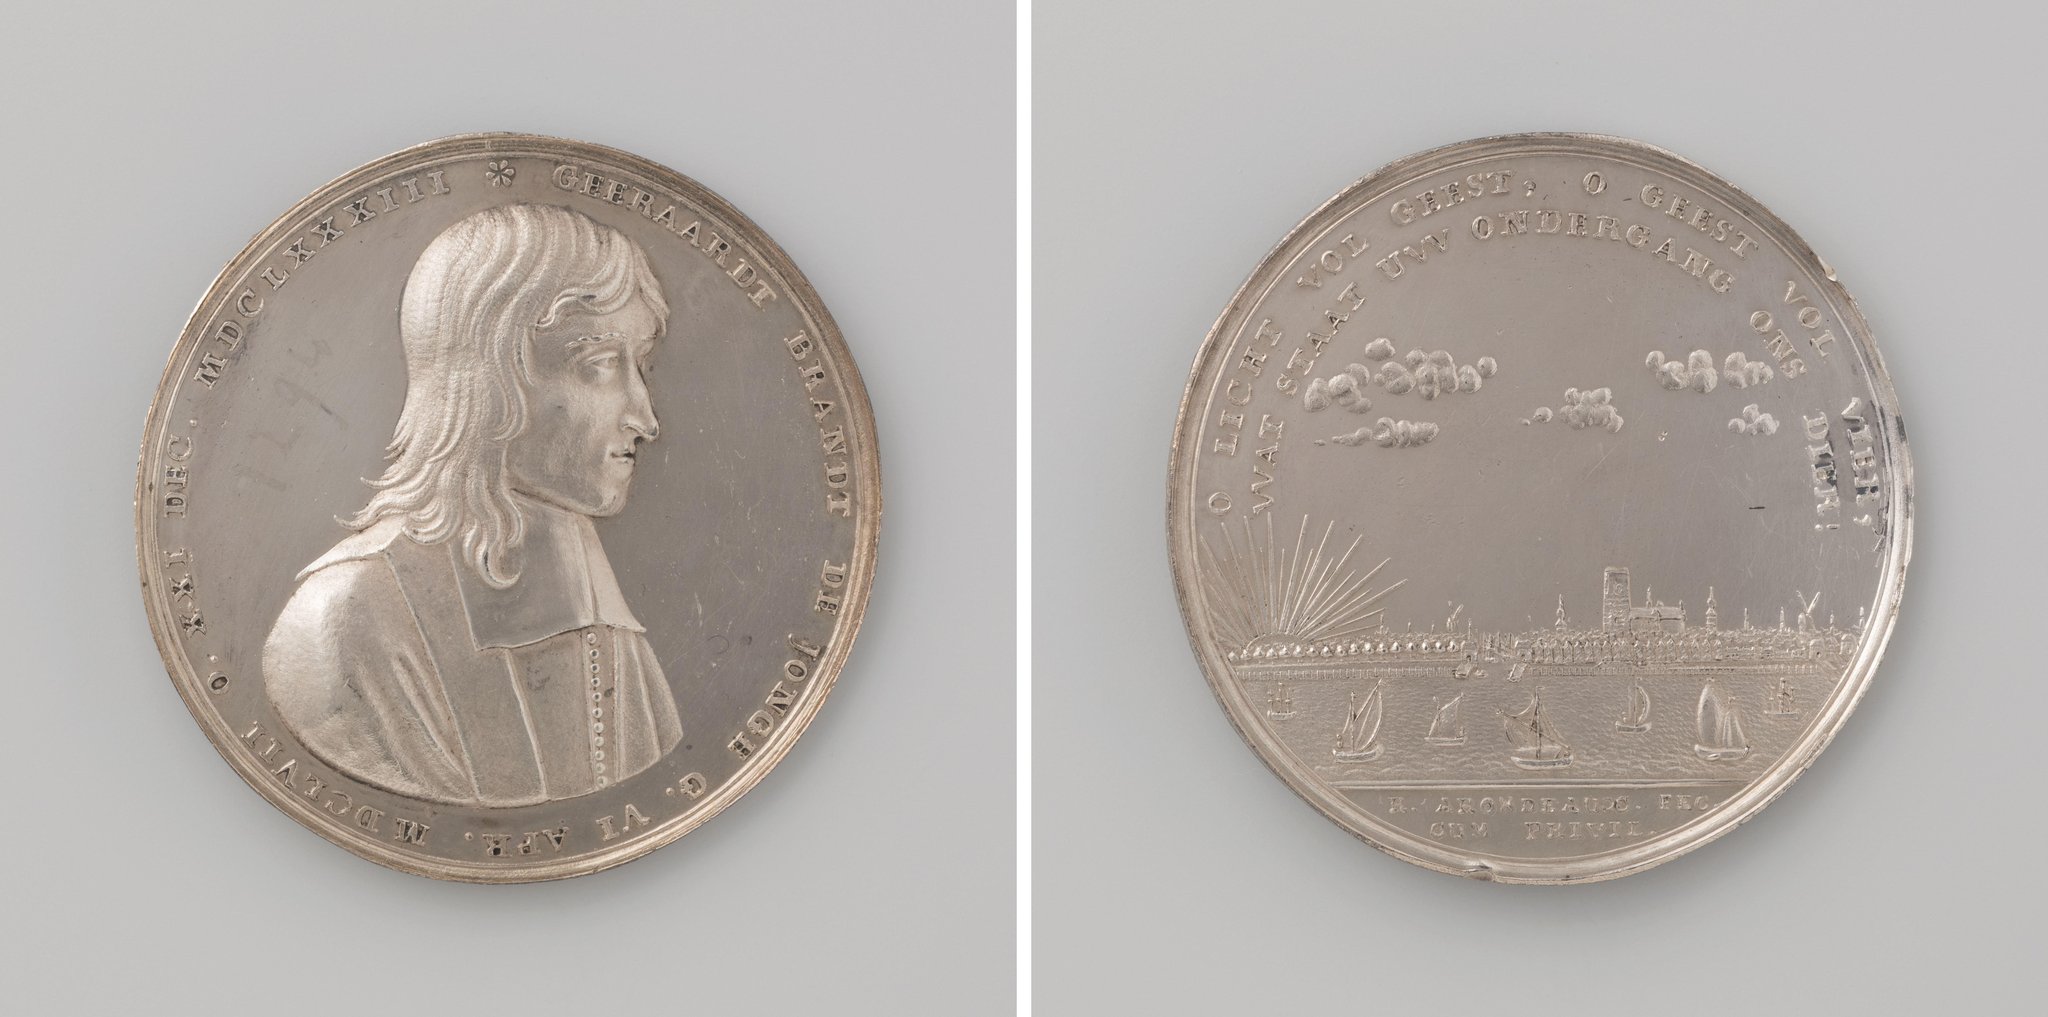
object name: history medal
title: Overlijden van Gerard Brandt de jonge, predikant te Rotterdam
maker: reynier arondeaux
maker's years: 1678-1727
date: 1683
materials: silver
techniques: striking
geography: amsterdam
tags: rotterdam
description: Zilveren penning. Voorzijde: borststuk man binnen omschrift. Keerzijde: stad aan rivier bij zonsondergang binnen omschrift